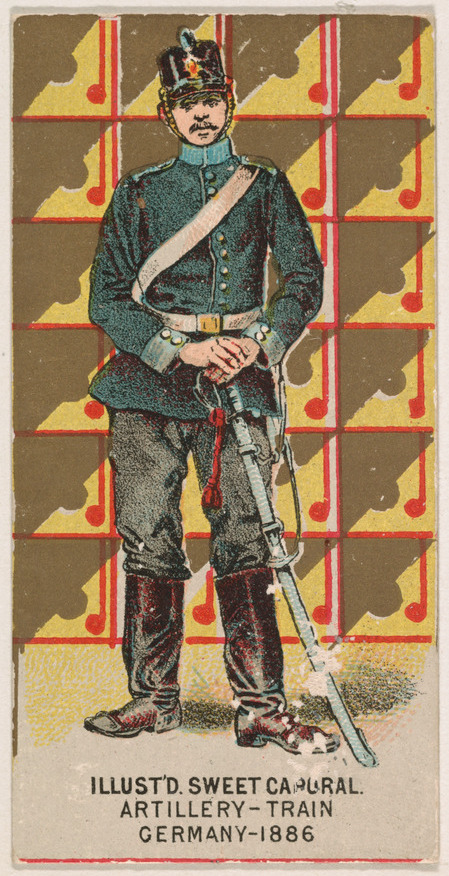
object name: print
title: Artillery, Train, Germany, 1886, from the Military Series (N224) issued by Kinney Tobacco Company to promote Sweet Caporal Cigarettes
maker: kinney brothers tobacco company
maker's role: publisher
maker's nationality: american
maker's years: 1869-2011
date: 1888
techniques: color lithograph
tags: military,men